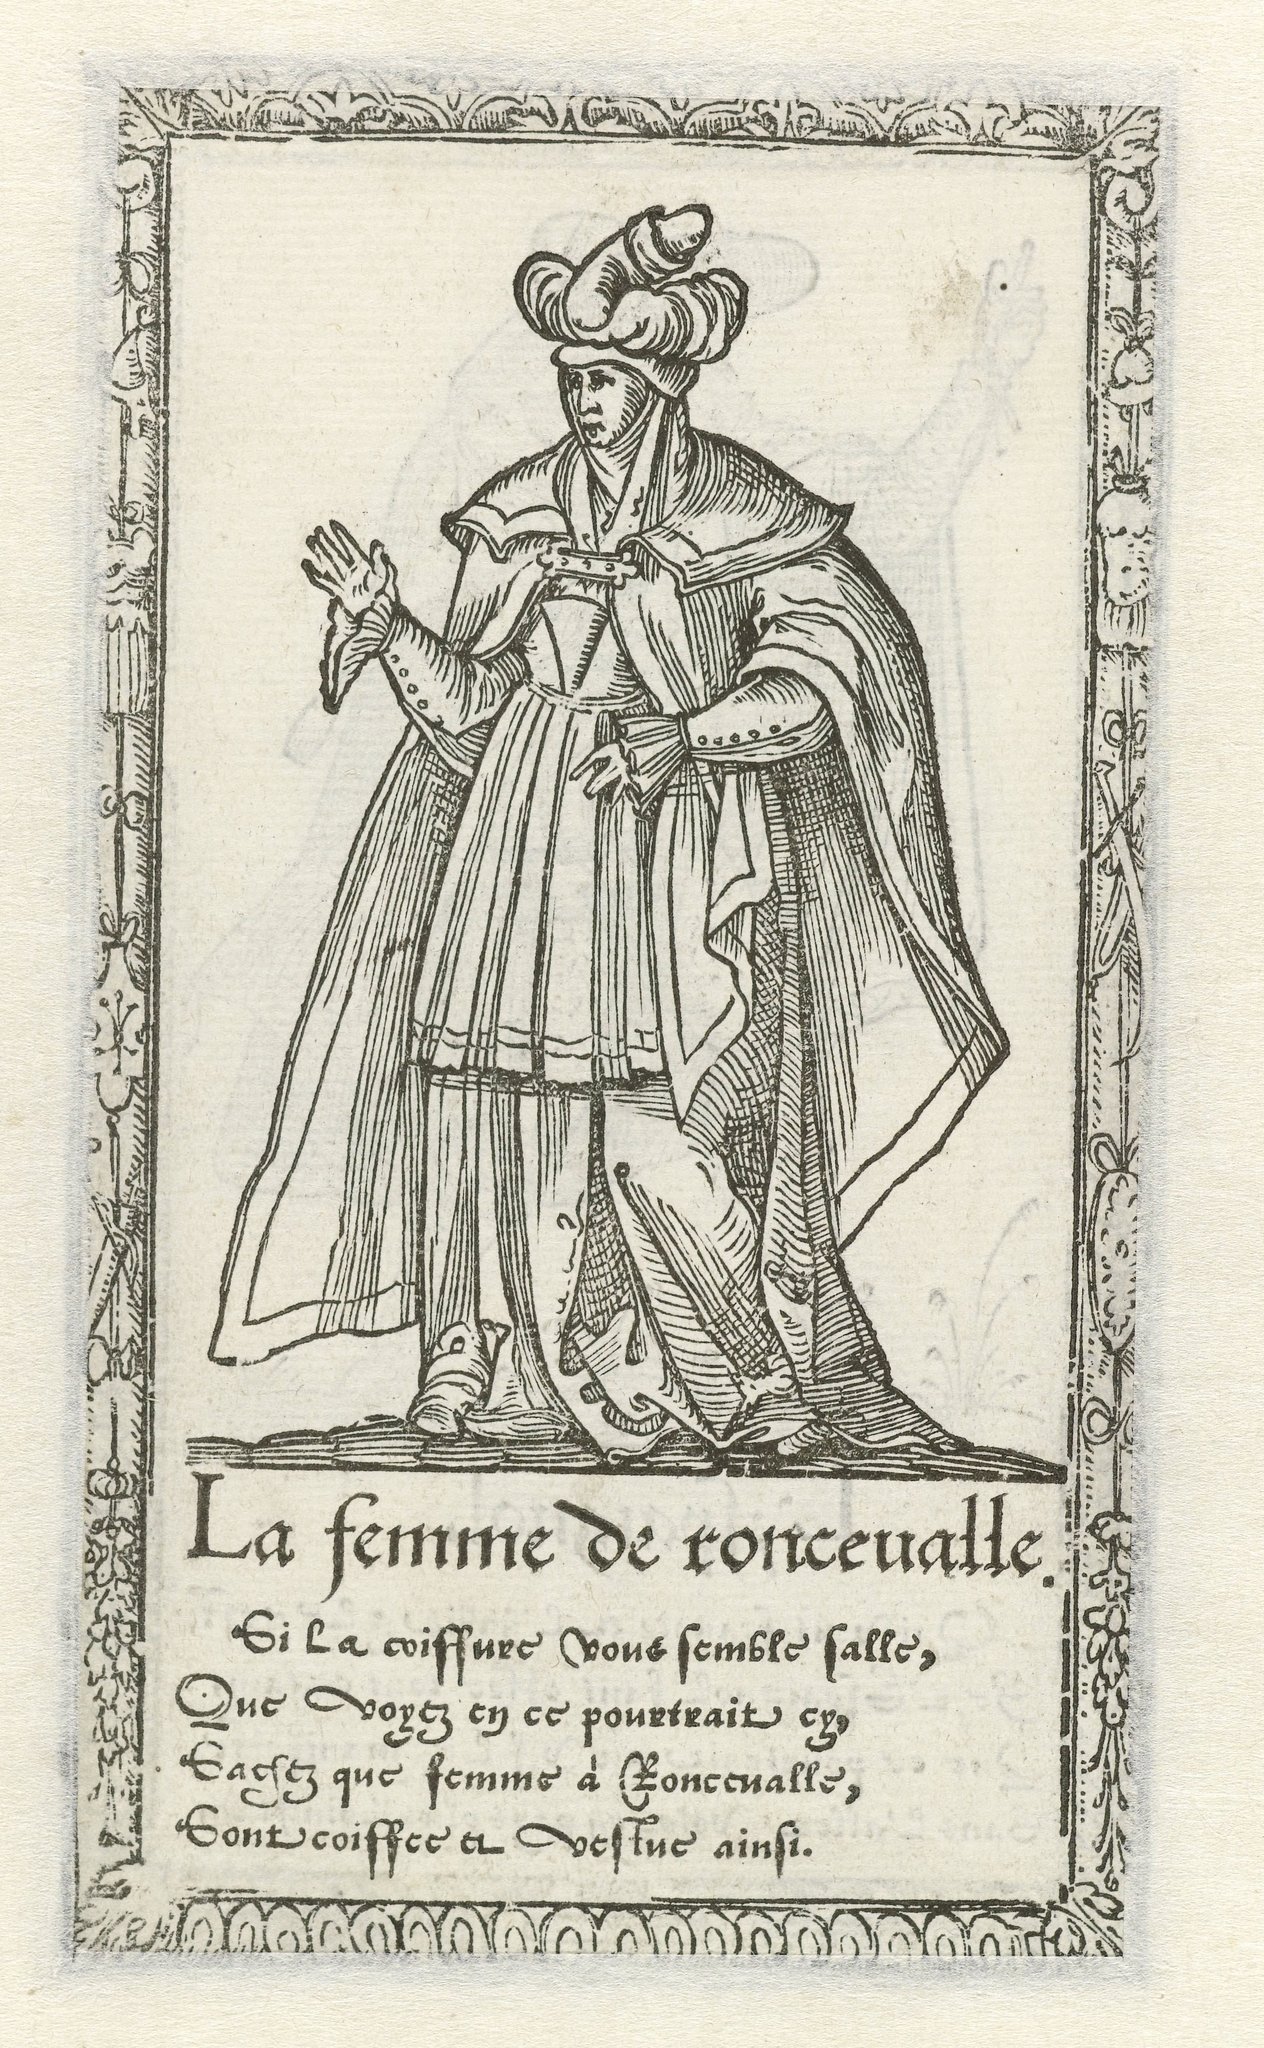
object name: print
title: La femme de roncevalle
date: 1562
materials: paper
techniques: woodcut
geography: paris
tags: europeans: spaniards (+ costume), fashion plates, folk costume, regional costume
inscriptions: collector's mark: Lugt 2228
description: Dit is prent 78 uit een serie van 121. Binnen deze serie zijn er prenten gemaakt naar voorbeelden van Jean-François de Roberval en Enea Vico, onbekend welke precies.